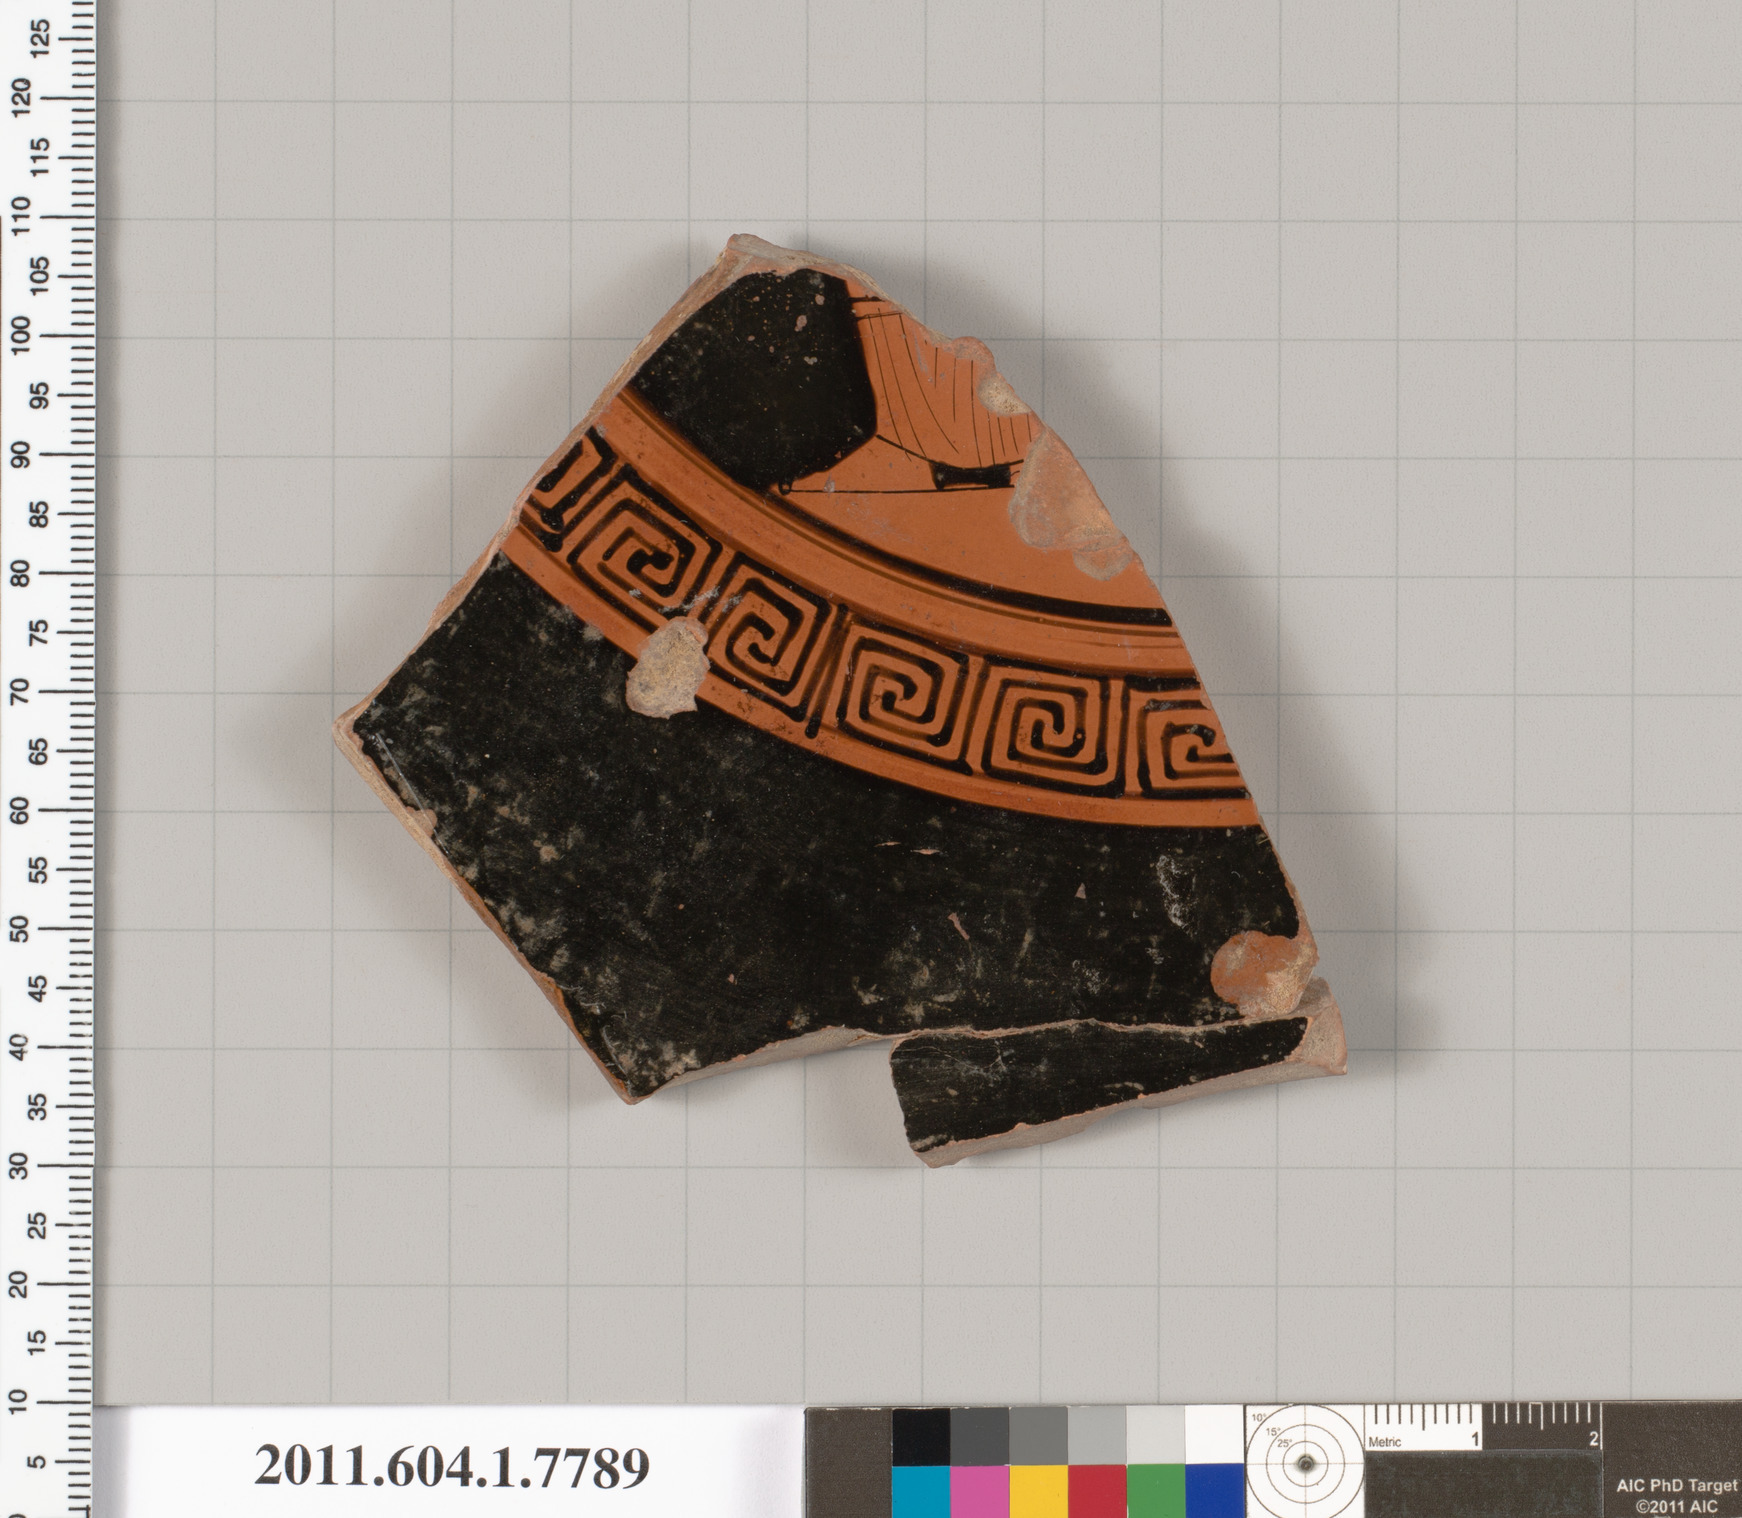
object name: kylix fragment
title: Terracotta fragment of a kylix (drinking cup)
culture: greek, attic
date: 460-450 BCE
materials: terracotta